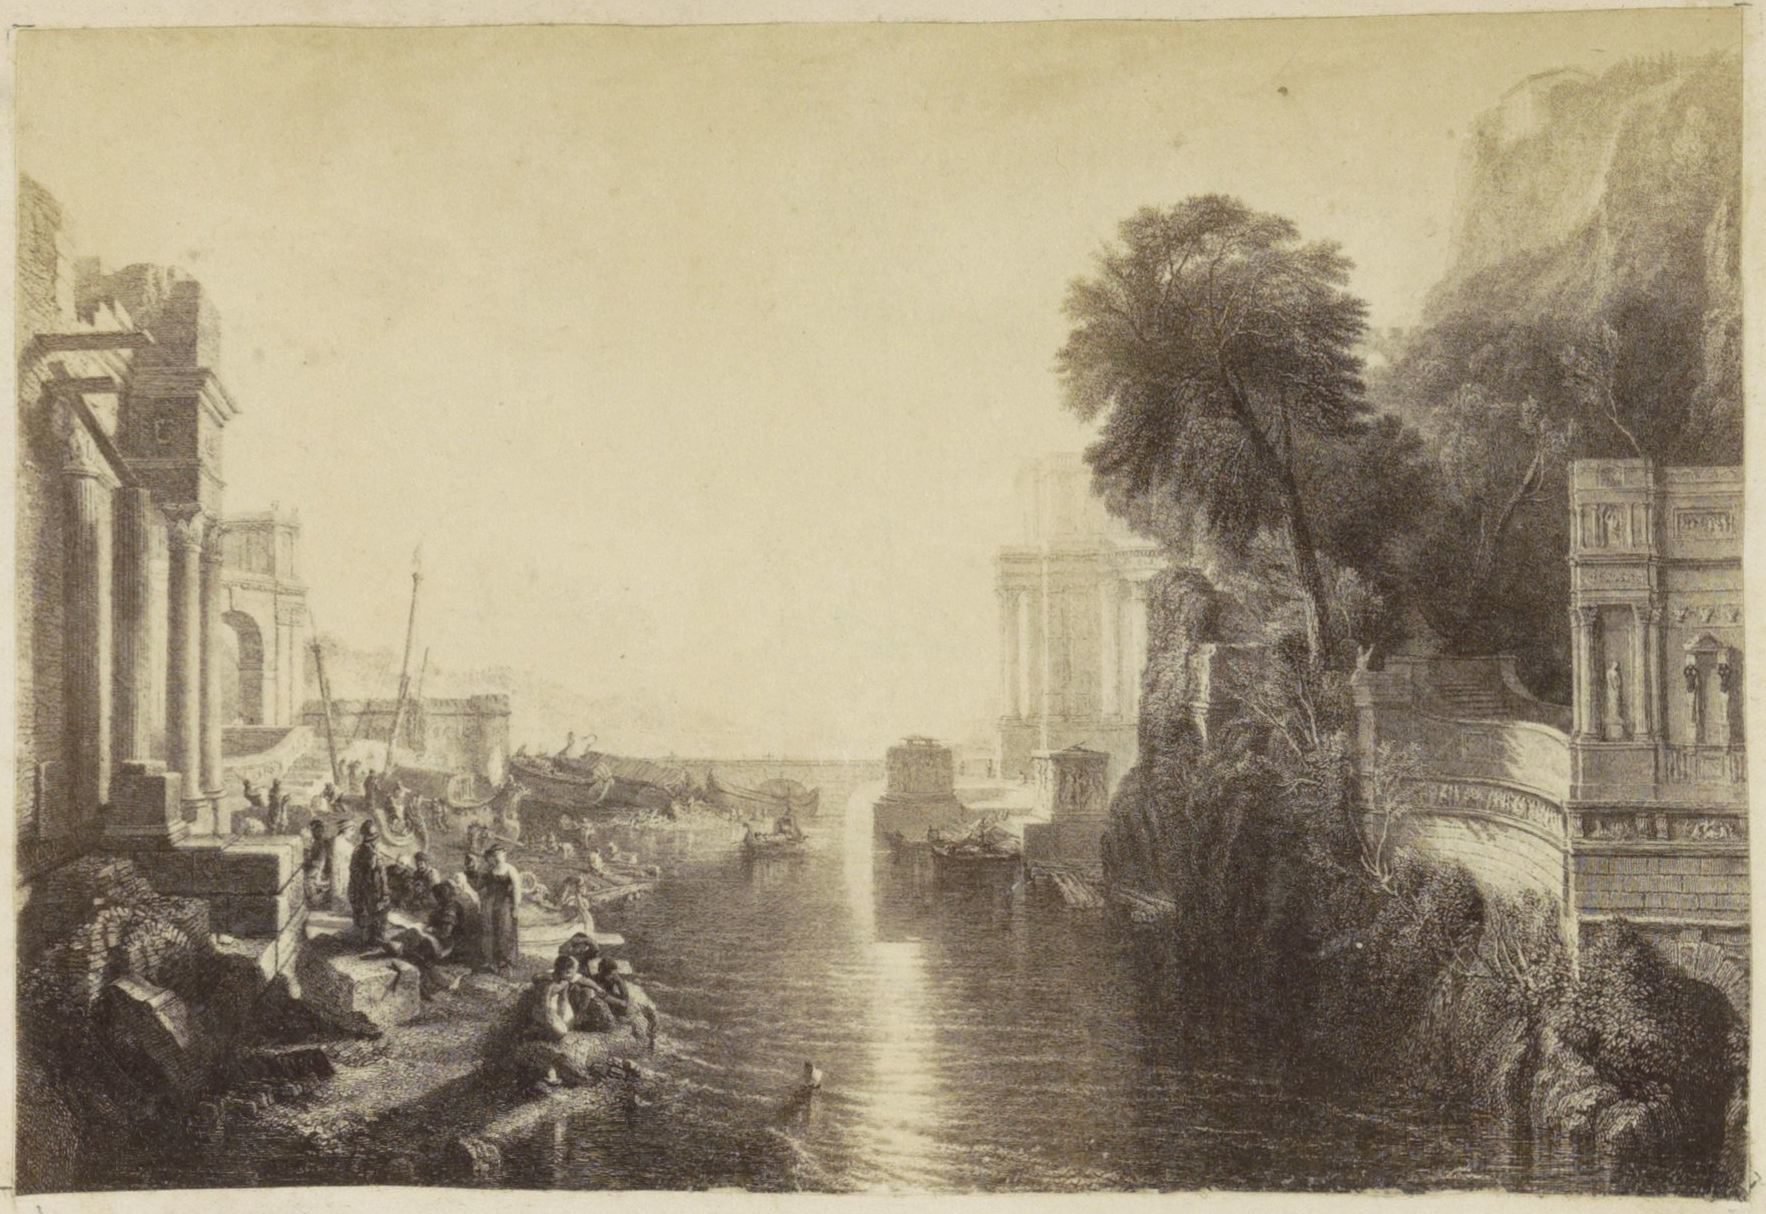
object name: reproduction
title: Fotoreproductie van (vermoedelijk) een prent naar een schilderij van J.M.T. Turner (Dido building Carthage)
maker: Anonymous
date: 1850-1870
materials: paper, photographic support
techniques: albumen print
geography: england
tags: dido founds carthage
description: Onderdeel van Album met foto's van bezienswaardigheden en landschappen in Engeland en van kunst.